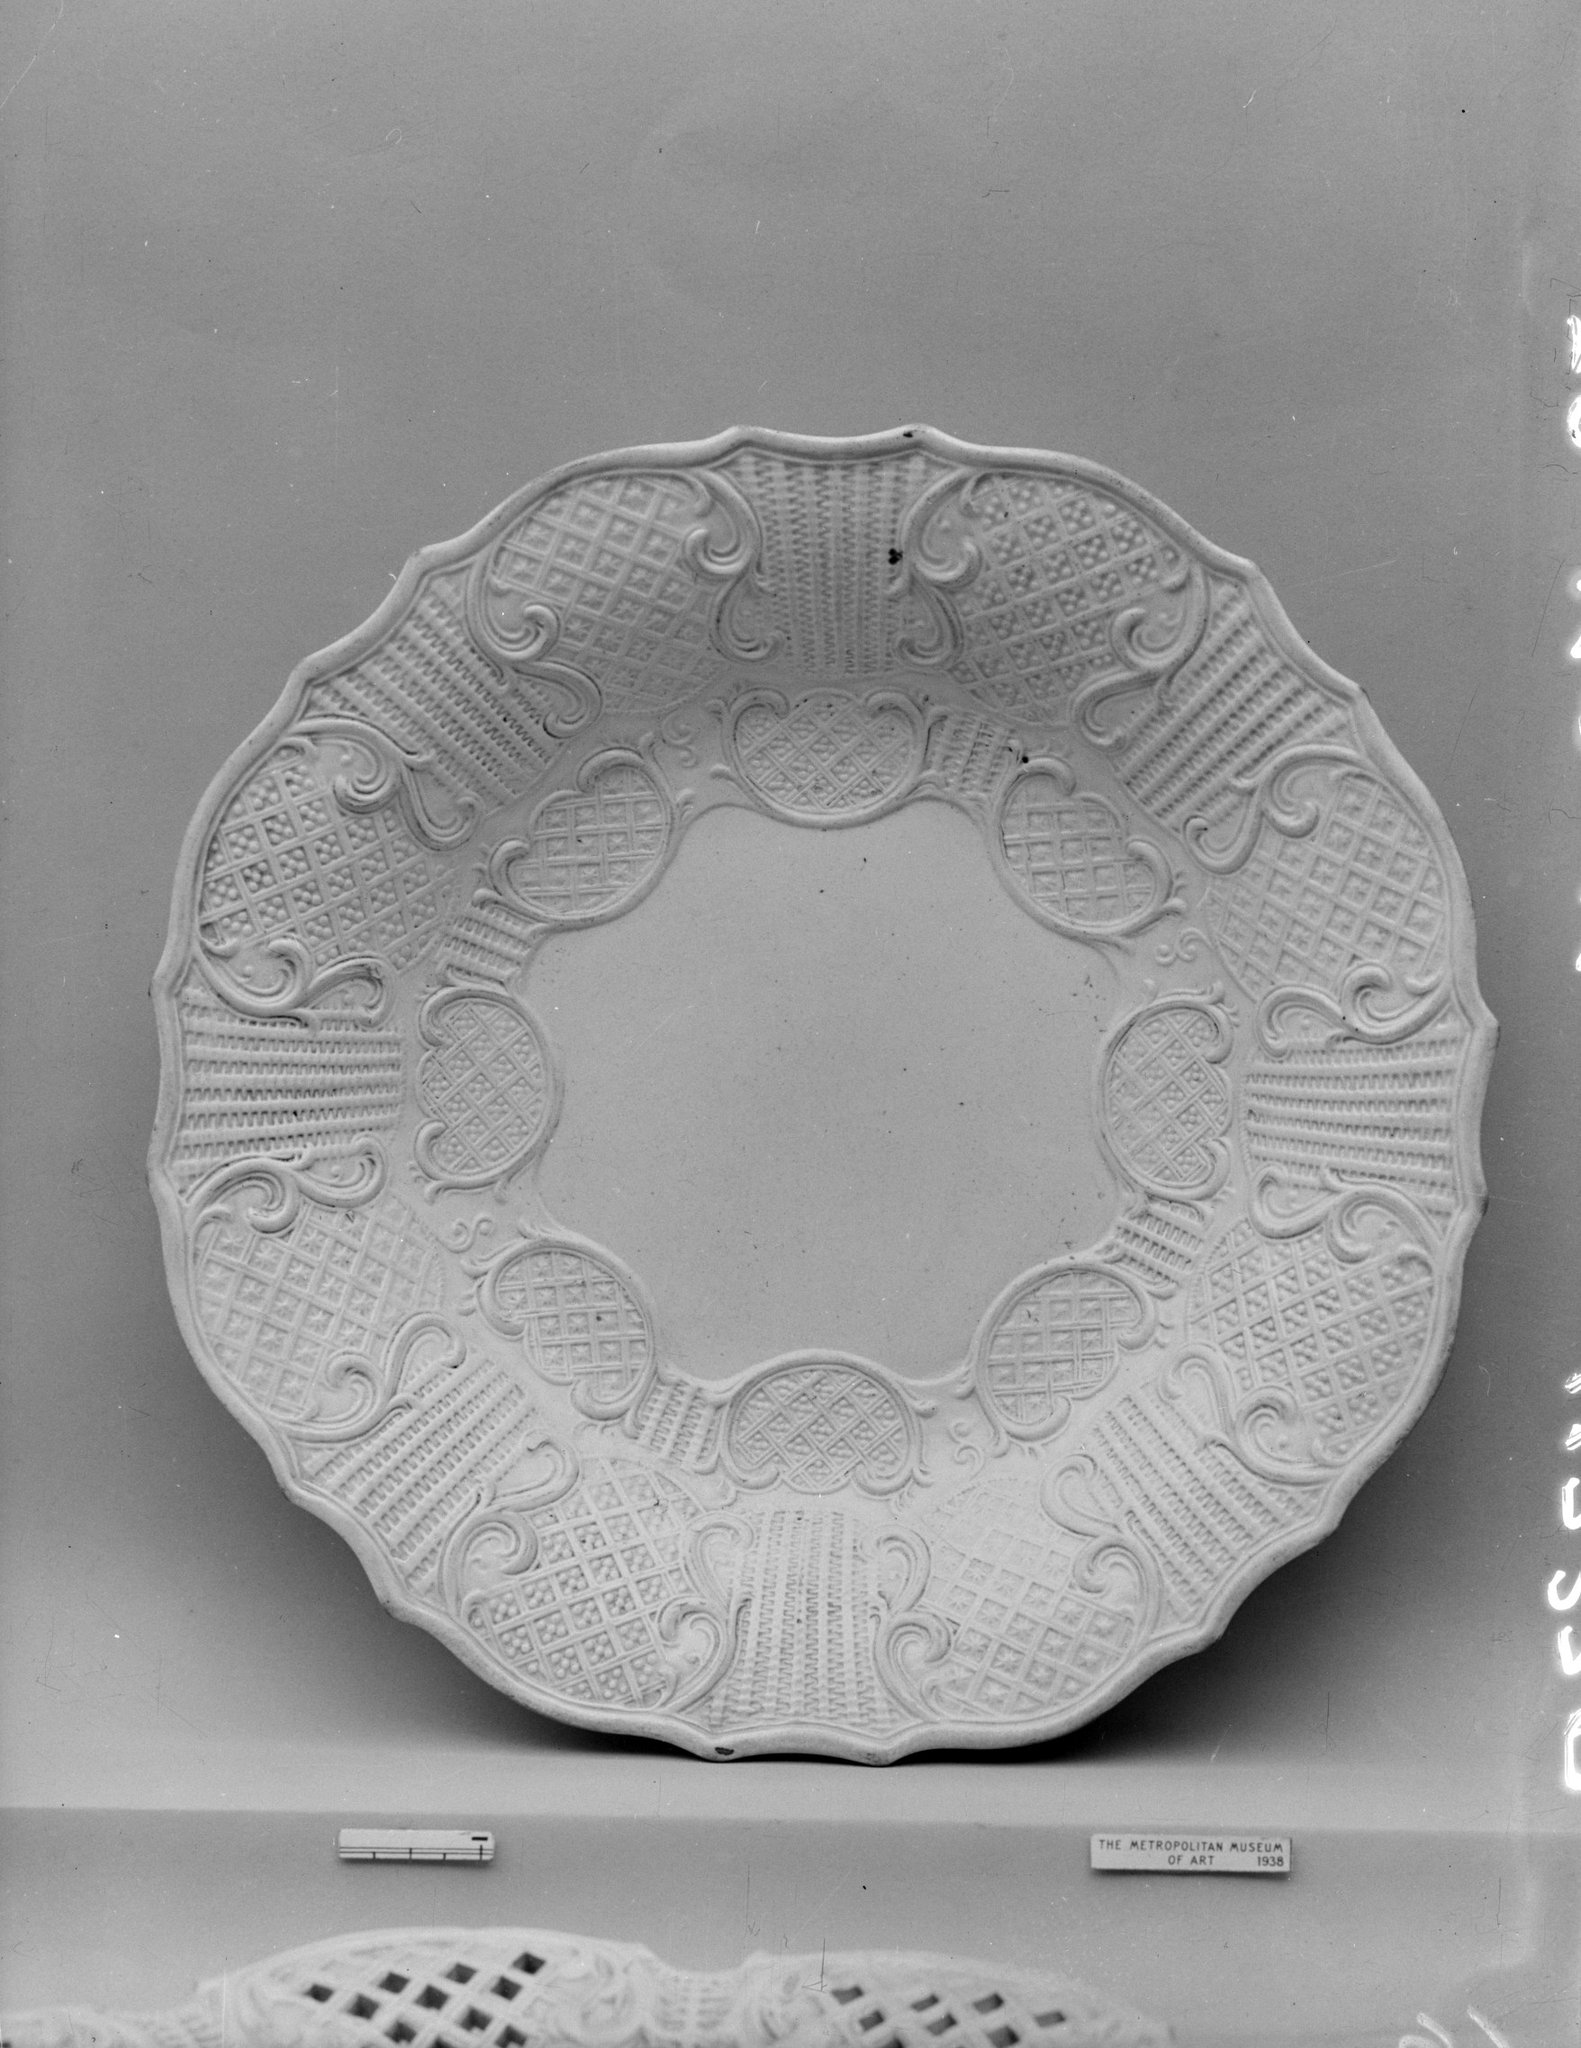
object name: plate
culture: british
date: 1750-1770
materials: stoneware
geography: england